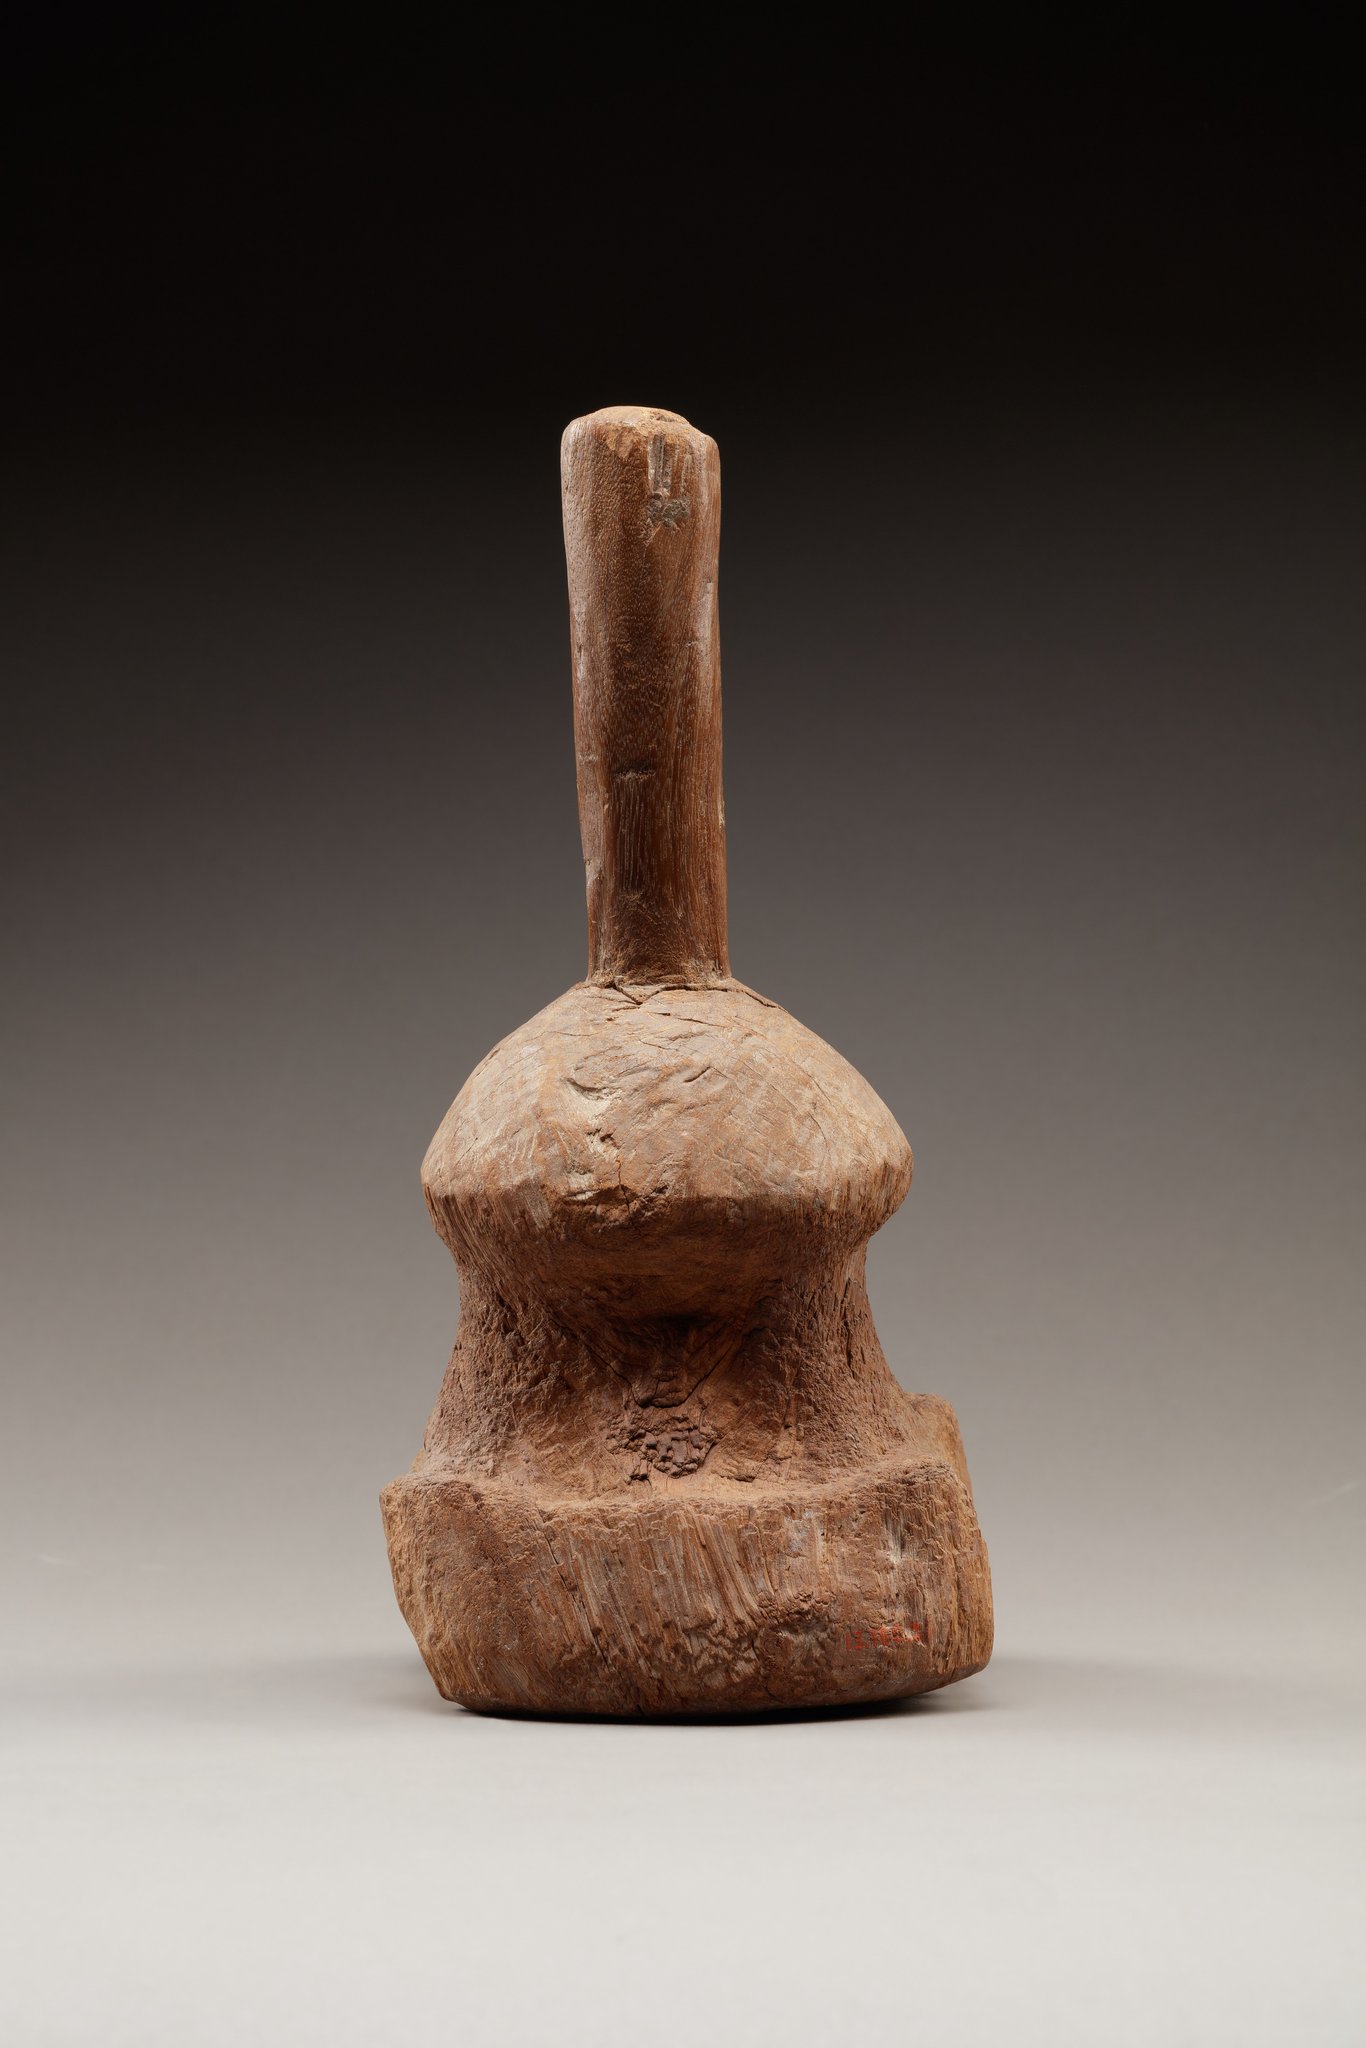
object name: mallet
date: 1200 BCE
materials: wood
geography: egypt